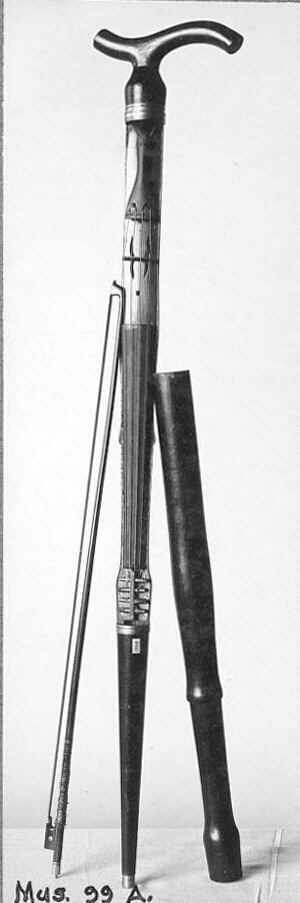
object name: cane violin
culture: german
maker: moritz wilhelm glaesel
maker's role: maker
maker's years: 1829-1917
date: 1801-1900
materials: wood, metal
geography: germany